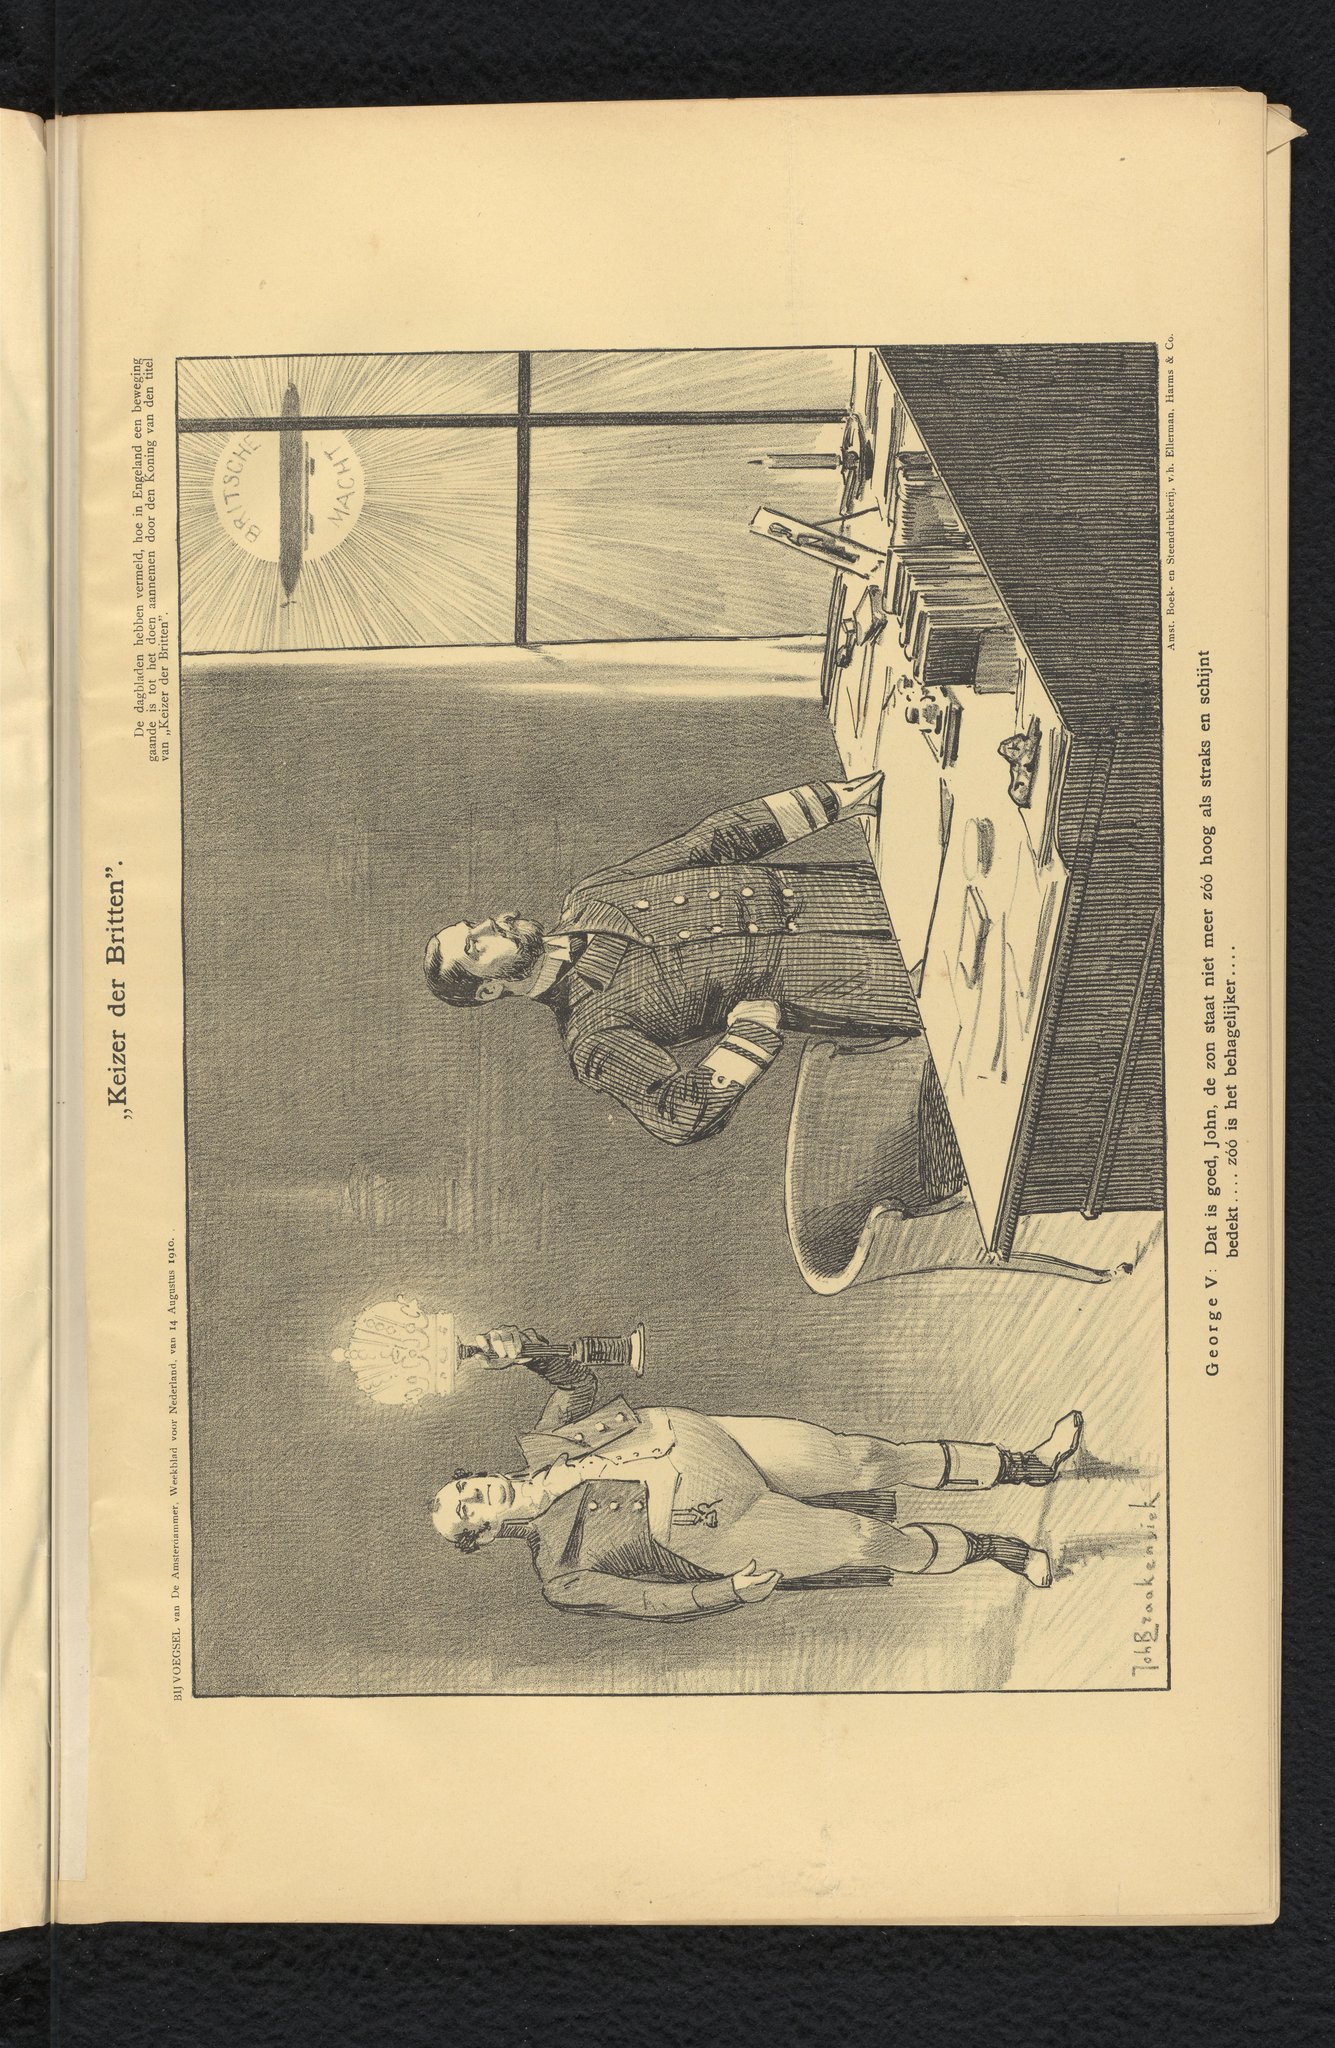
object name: cartoon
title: "Keizer der Britten"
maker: johan braakensiek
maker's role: draughtsman, print maker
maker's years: 1858-1940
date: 1910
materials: paper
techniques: lithograph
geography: amsterdam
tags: personifications of countries, nations, states, districts, etc., 46c35 airship, zeppelin, lighting; lamps, political caricatures and satires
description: John Bull (Engeland) brengt een lamp met stralende keizerskroon naar de Britse koning George V, die ziet dat het licht van de 'Britsche Macht' tijdelijk wordt verduisterd door een Duits luchtschip.